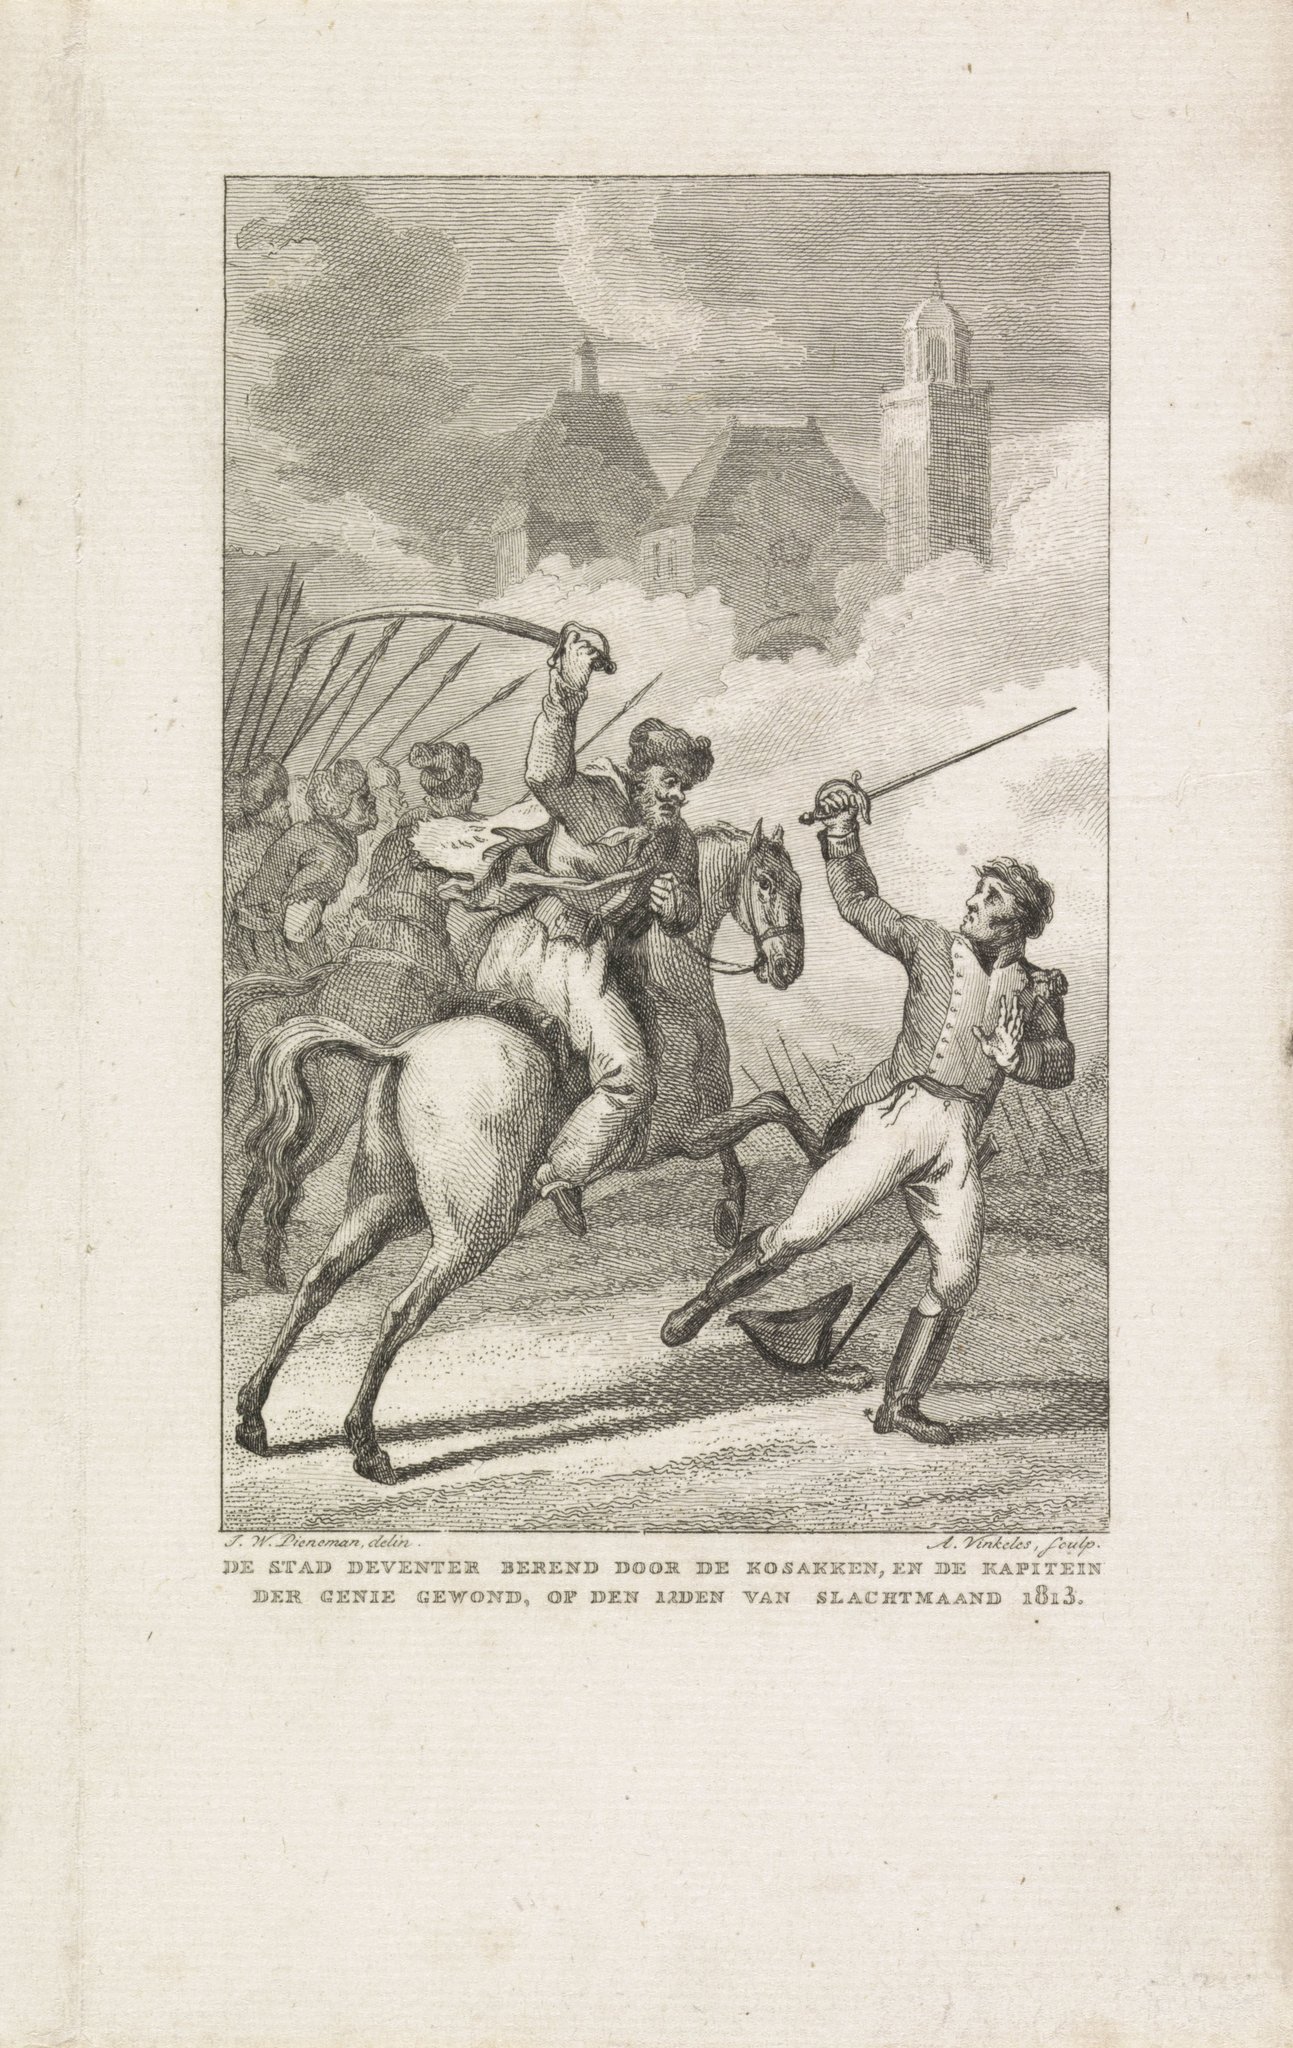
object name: print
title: De stad Deventer berend door de kosakken, en de kapitein der Genie gewond, op den 12den van slachtmaand 1813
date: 1814-1816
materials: paper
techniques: engraving, etching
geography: netherlands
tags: being attacked; defence, deventer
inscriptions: collector's mark: Lugt 2228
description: Gebruikt als illustratie in: J. Konijnenburg, Nationaal gedenkboek der hernieuwde Nederlandsche Unie, van den jare 1813, 's-Gravenhage: Johannes Allart, 1816.